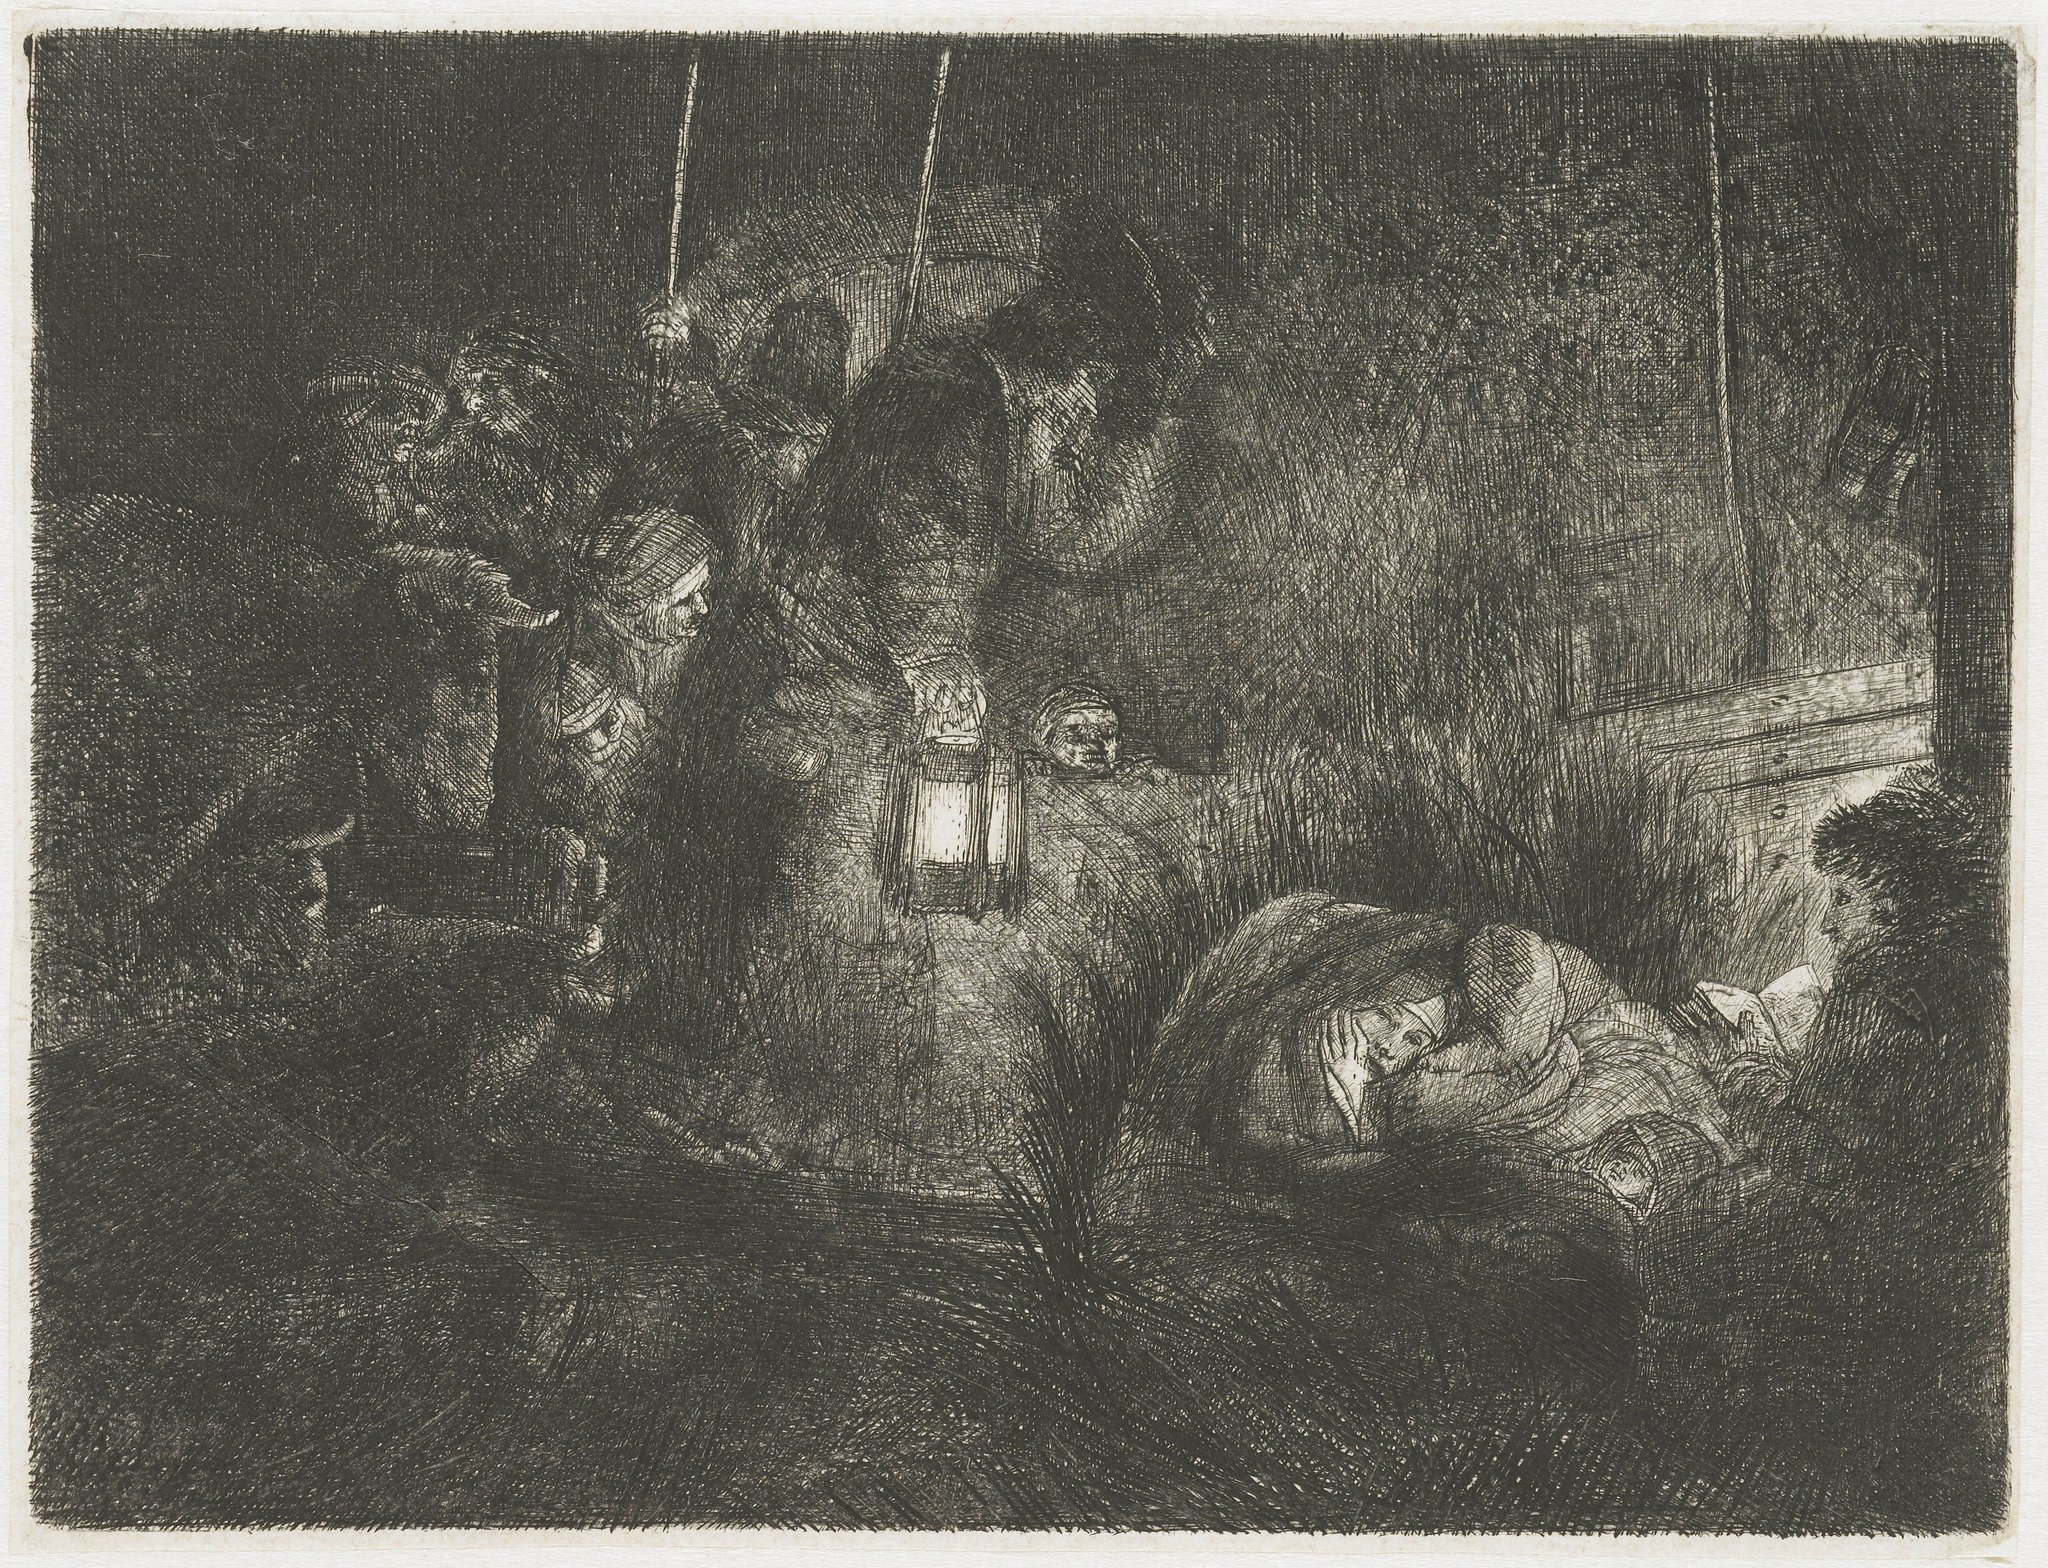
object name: print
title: The adoration of the shepherds: a night piece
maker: rembrandt van rijn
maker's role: draughtsman, painter, print maker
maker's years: 1606-1669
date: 1657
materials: paper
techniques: drypoint, etching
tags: adoration of the christ-child by the shepherds; mary and joseph present